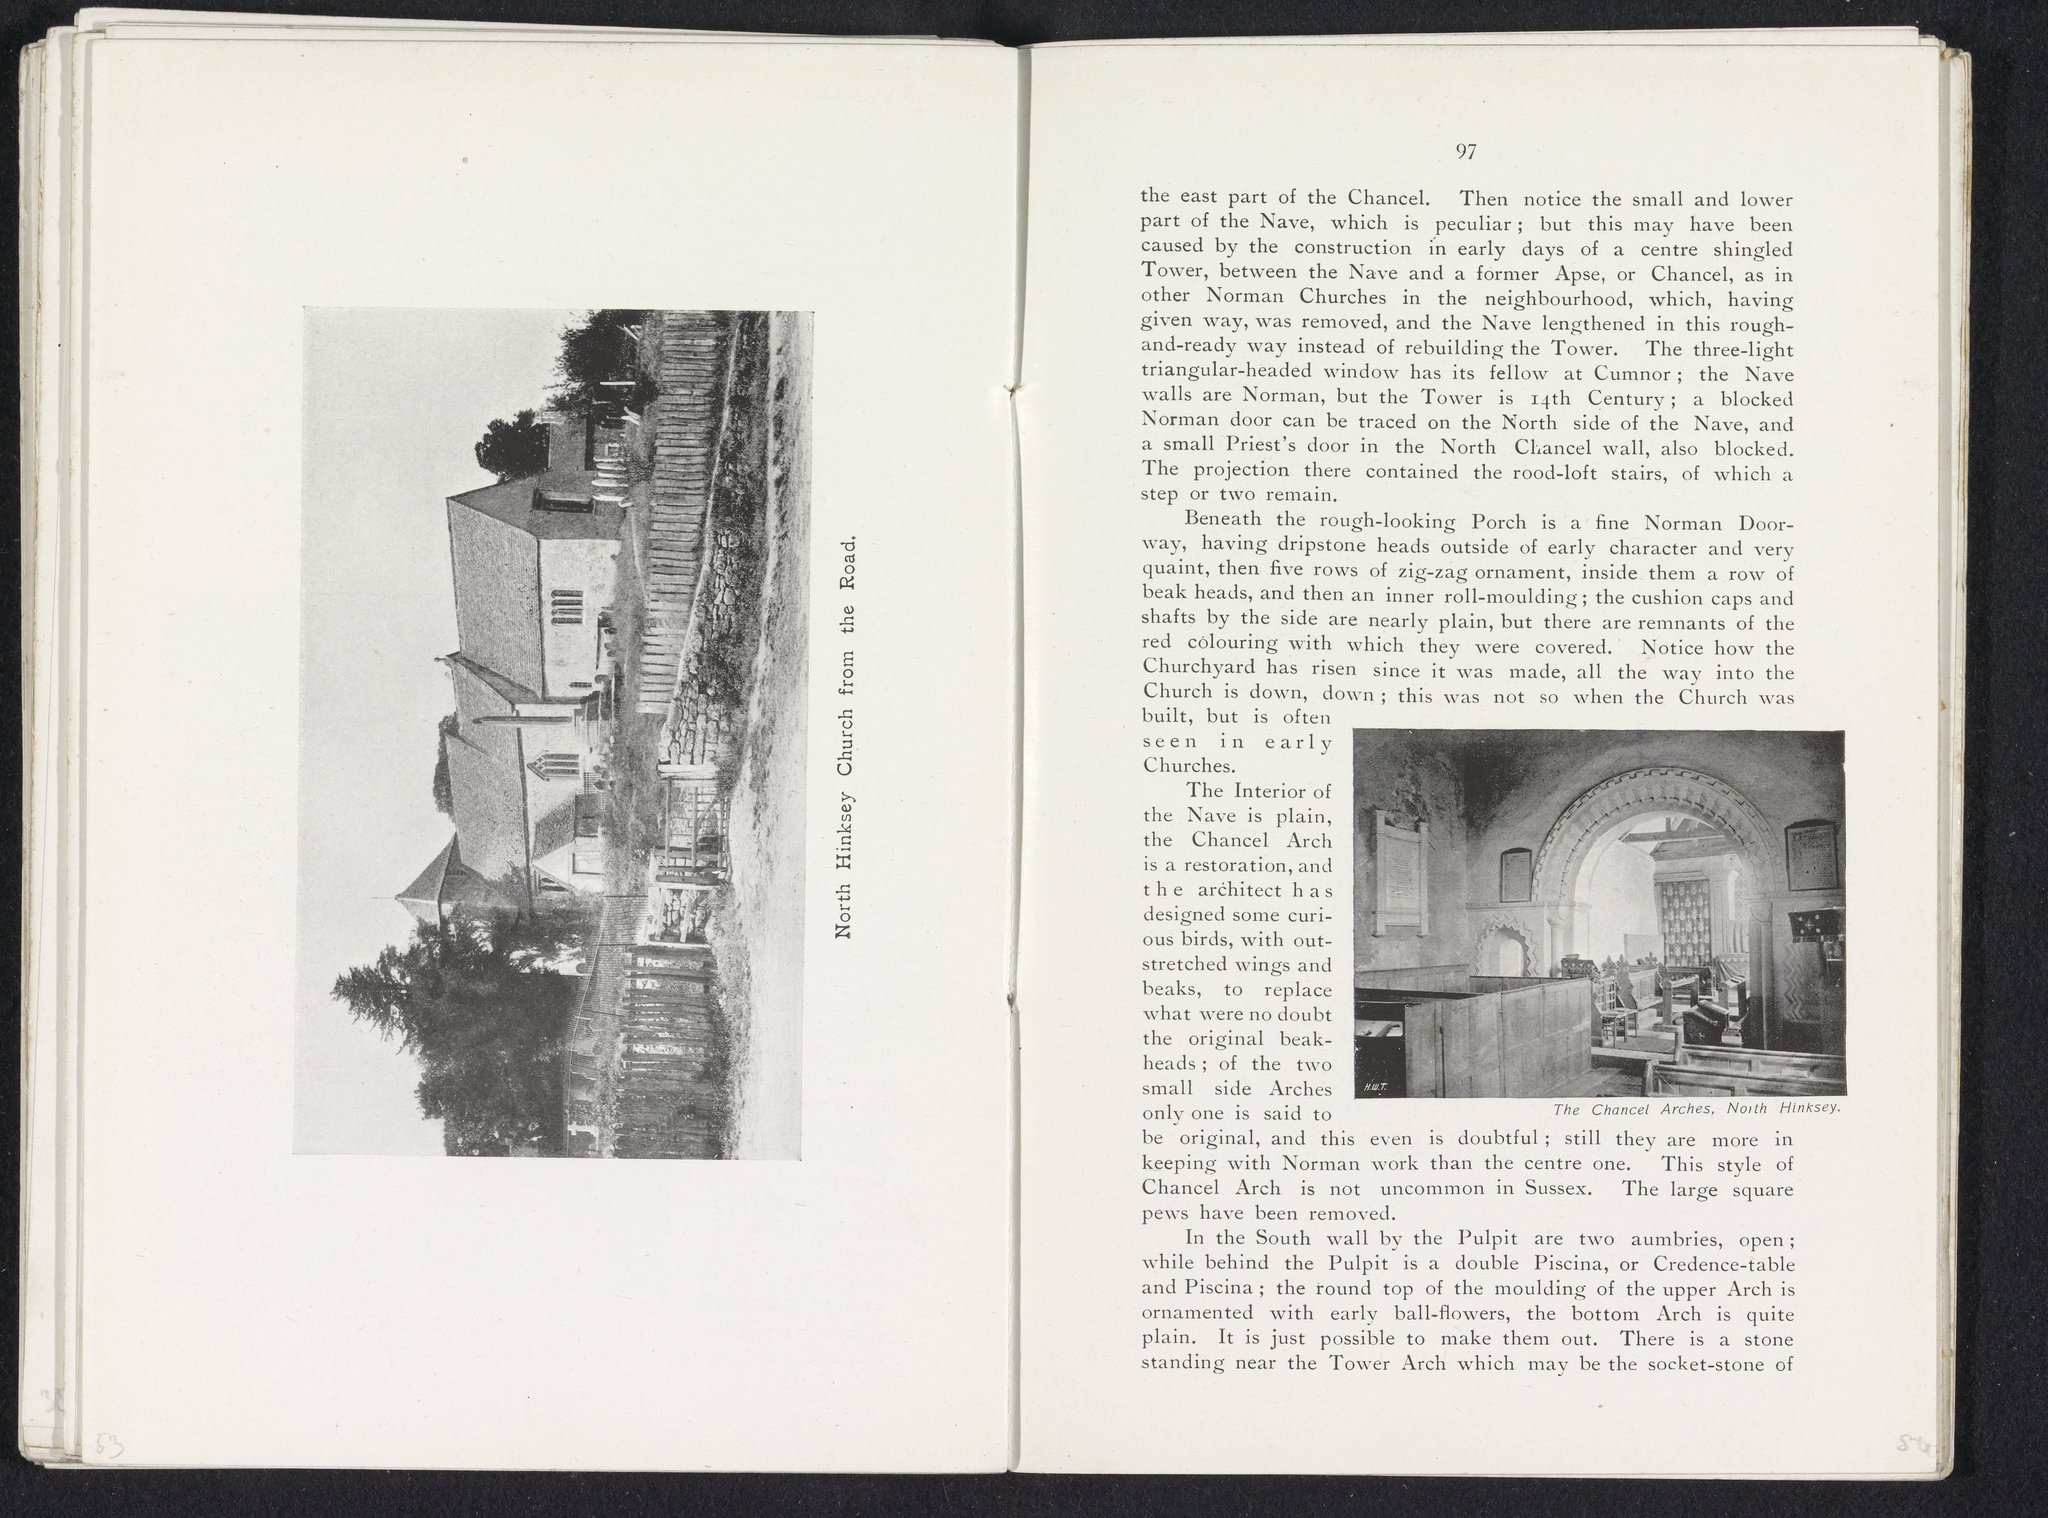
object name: page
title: North Hinksey Church from the road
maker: henry w. taunt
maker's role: fotograaf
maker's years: 1842-1922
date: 1907-1912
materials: paper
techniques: autotype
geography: north hinksey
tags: church (exterior)